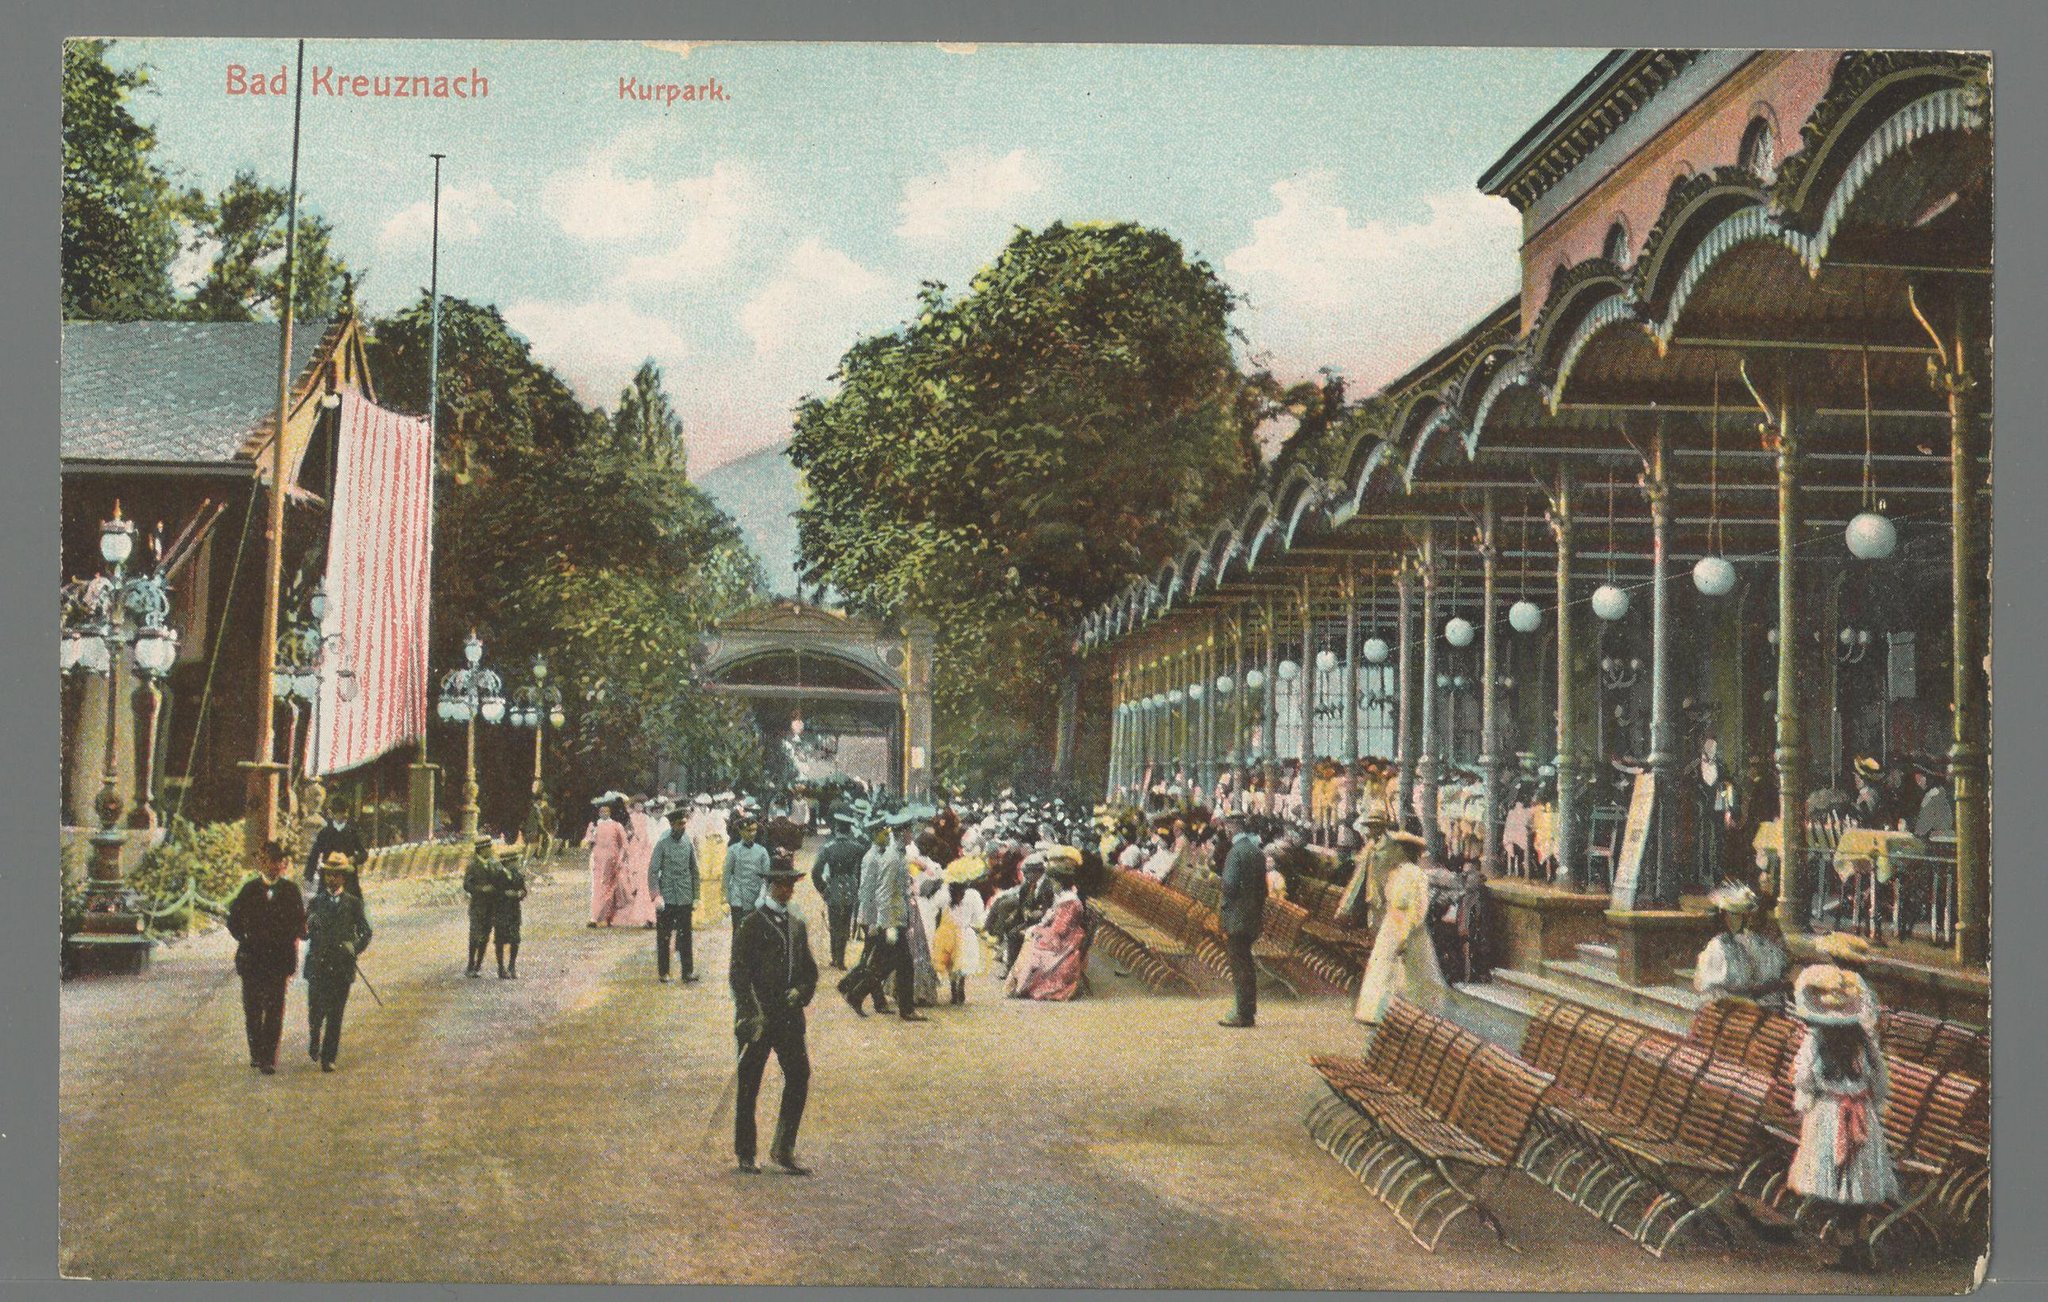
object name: photomechanical print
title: Bad Kreuznach. Kurpark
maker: Anonymous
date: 1907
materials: cardboard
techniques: lithograph, writing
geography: bad kreuznach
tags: park, restaurant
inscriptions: date